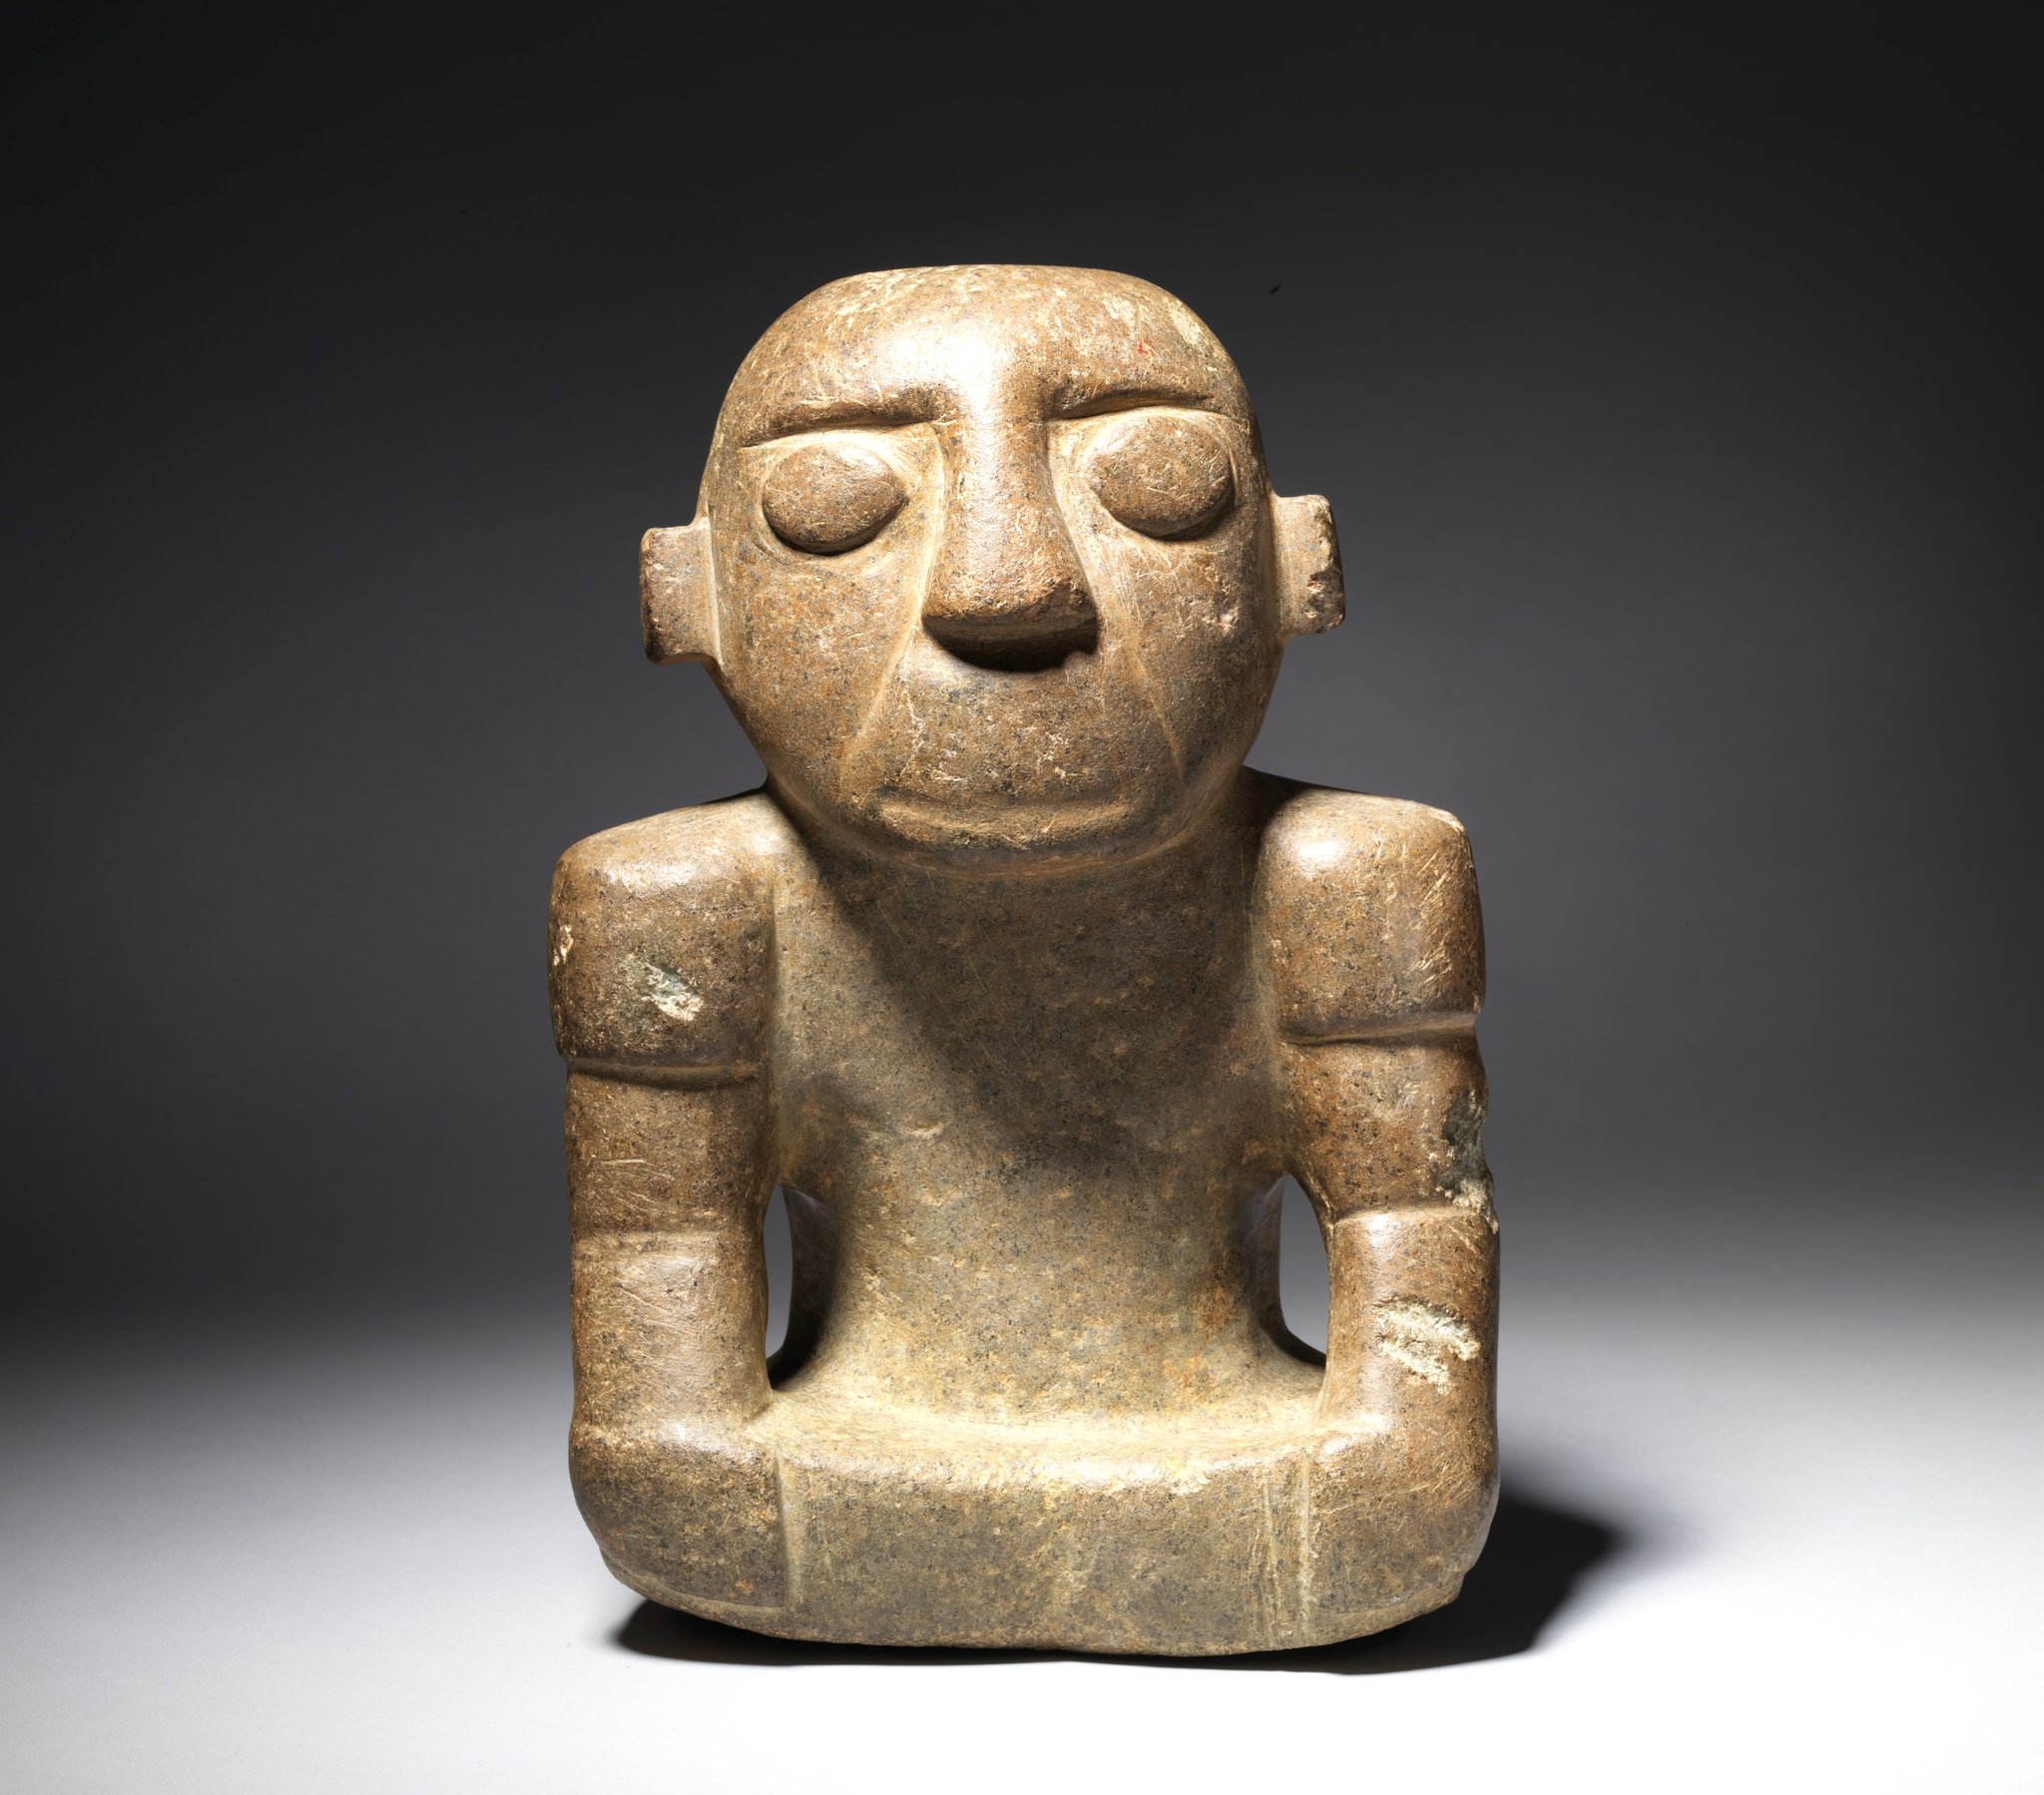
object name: figure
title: Seated Figure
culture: guerrero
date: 400-100 BCE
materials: stone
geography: mexico